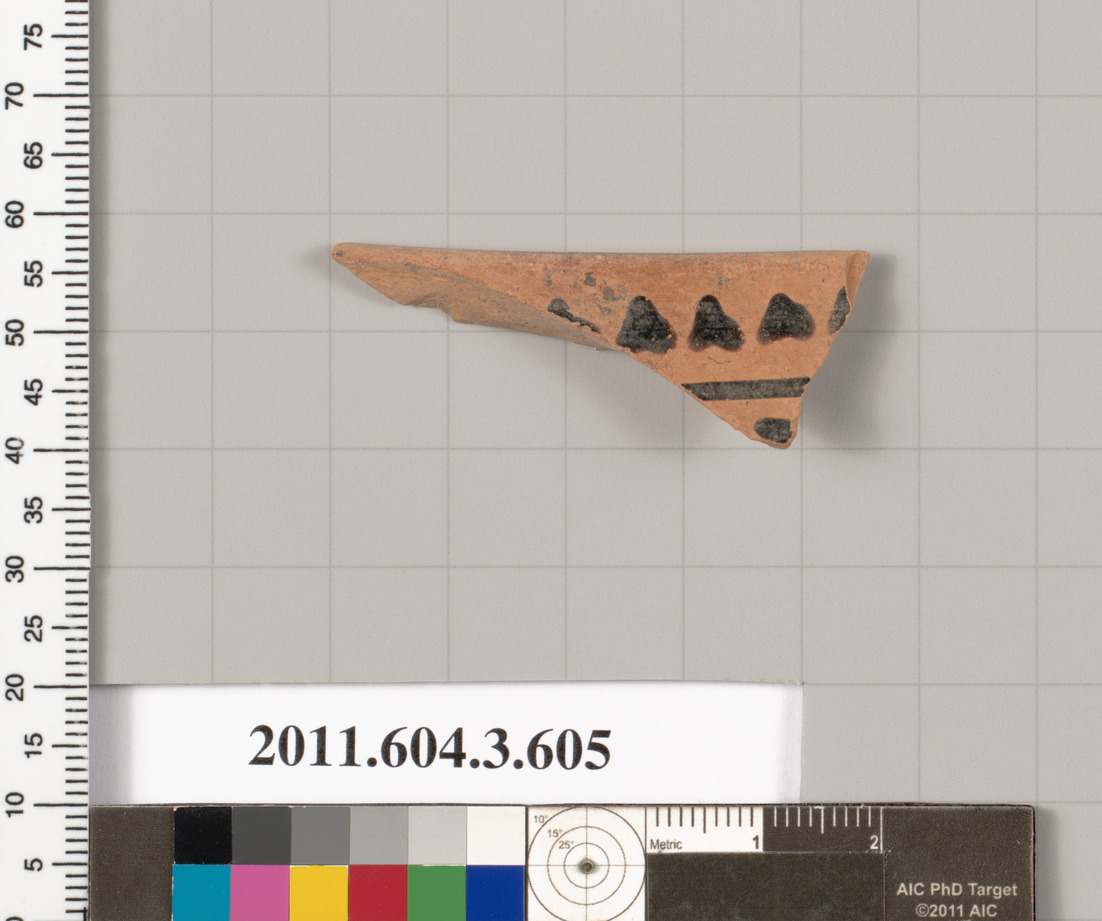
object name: column krater fragment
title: Terracotta fragment of a column-krater (bowl for mixing wine and water)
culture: greek, attic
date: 525-501 BCE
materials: terracotta